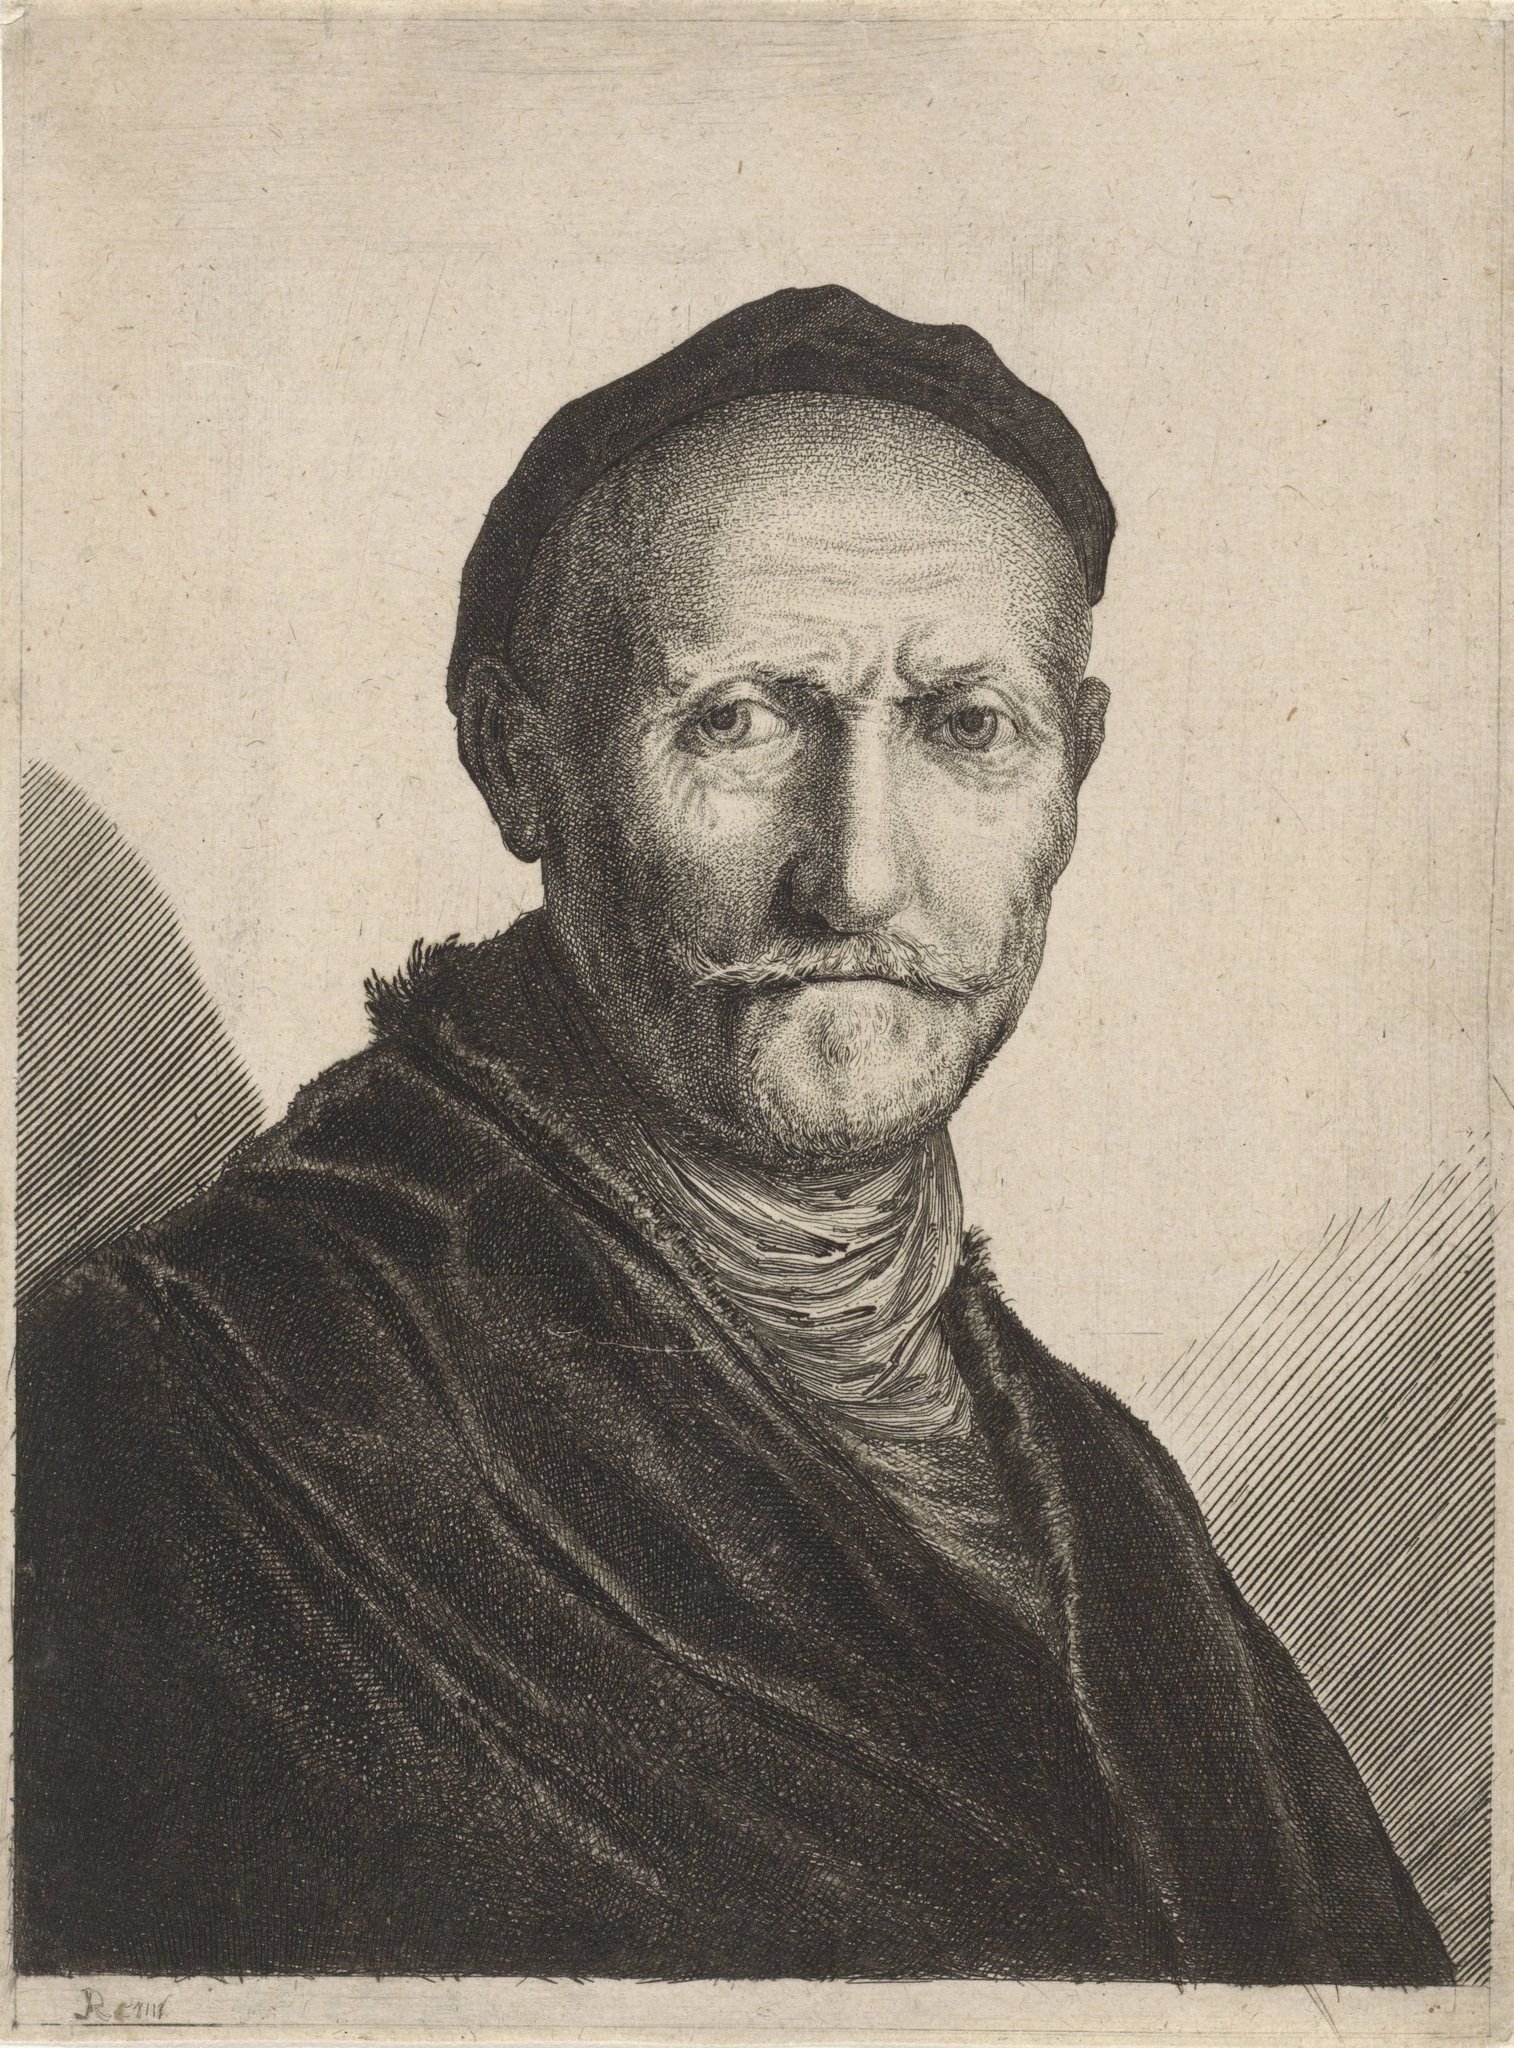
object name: print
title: Portret van een oudere man met een baret op zijn hoofd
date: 1633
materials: paper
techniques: engraving, etching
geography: amsterdam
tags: anonymous historical person portrayed alone, old man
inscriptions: collector's mark: Lugt 240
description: Portret tevens gebruikt in: Schabaelje, Jan Philipsz. Den grooten emblemata sacra, bestaande in meer dan drie hondert bybelsche figueren, soo des Ouden als des Nieuwen Testaments. Amsterdam: Tymon Houthaeck en Jan Philipsz Schabaelje, 1654. De oudere man verbeeldt hier het Romeinse staatsmanschap.